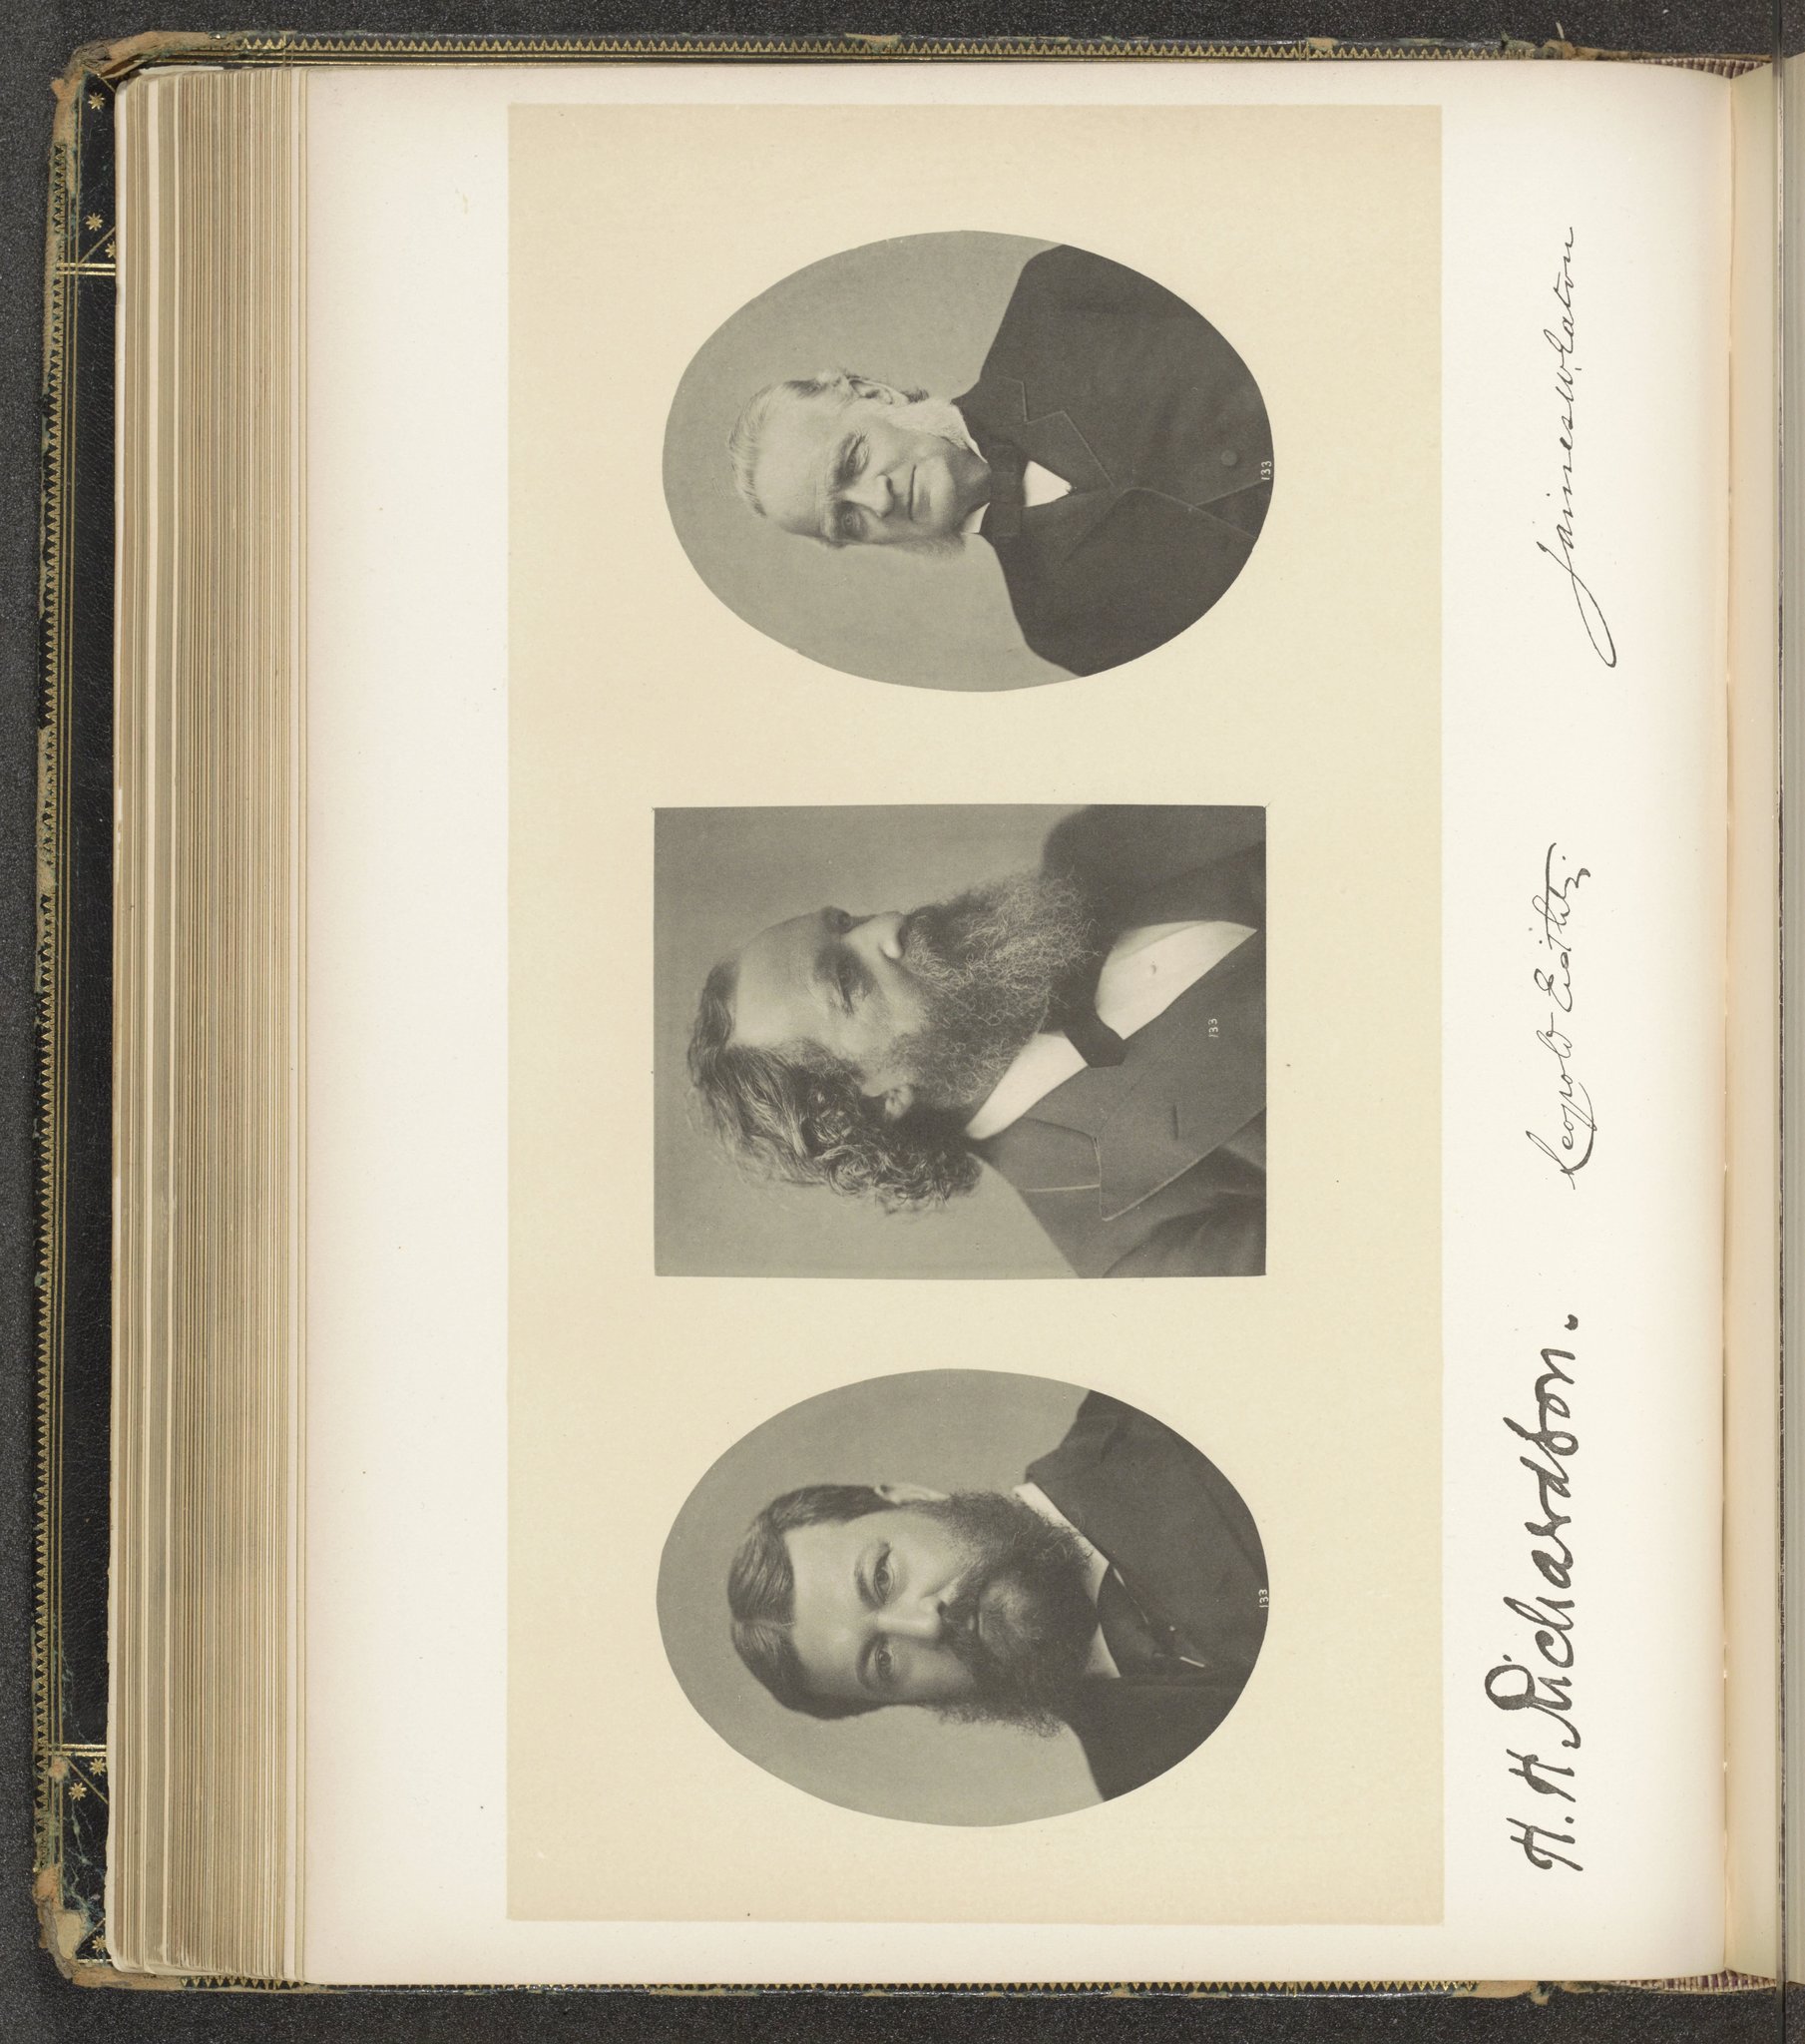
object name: page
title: Drie portretten van leden van de Capitoolcommissie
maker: Anonymous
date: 1872-1882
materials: paper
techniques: photograph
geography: united states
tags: historical persons (+ head (and shoulders) (portrait))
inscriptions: annotation, number: ‘133’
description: Links Henry Hobson Richardson, midden Leopold Eidlitz, rechts James W. Eaton.